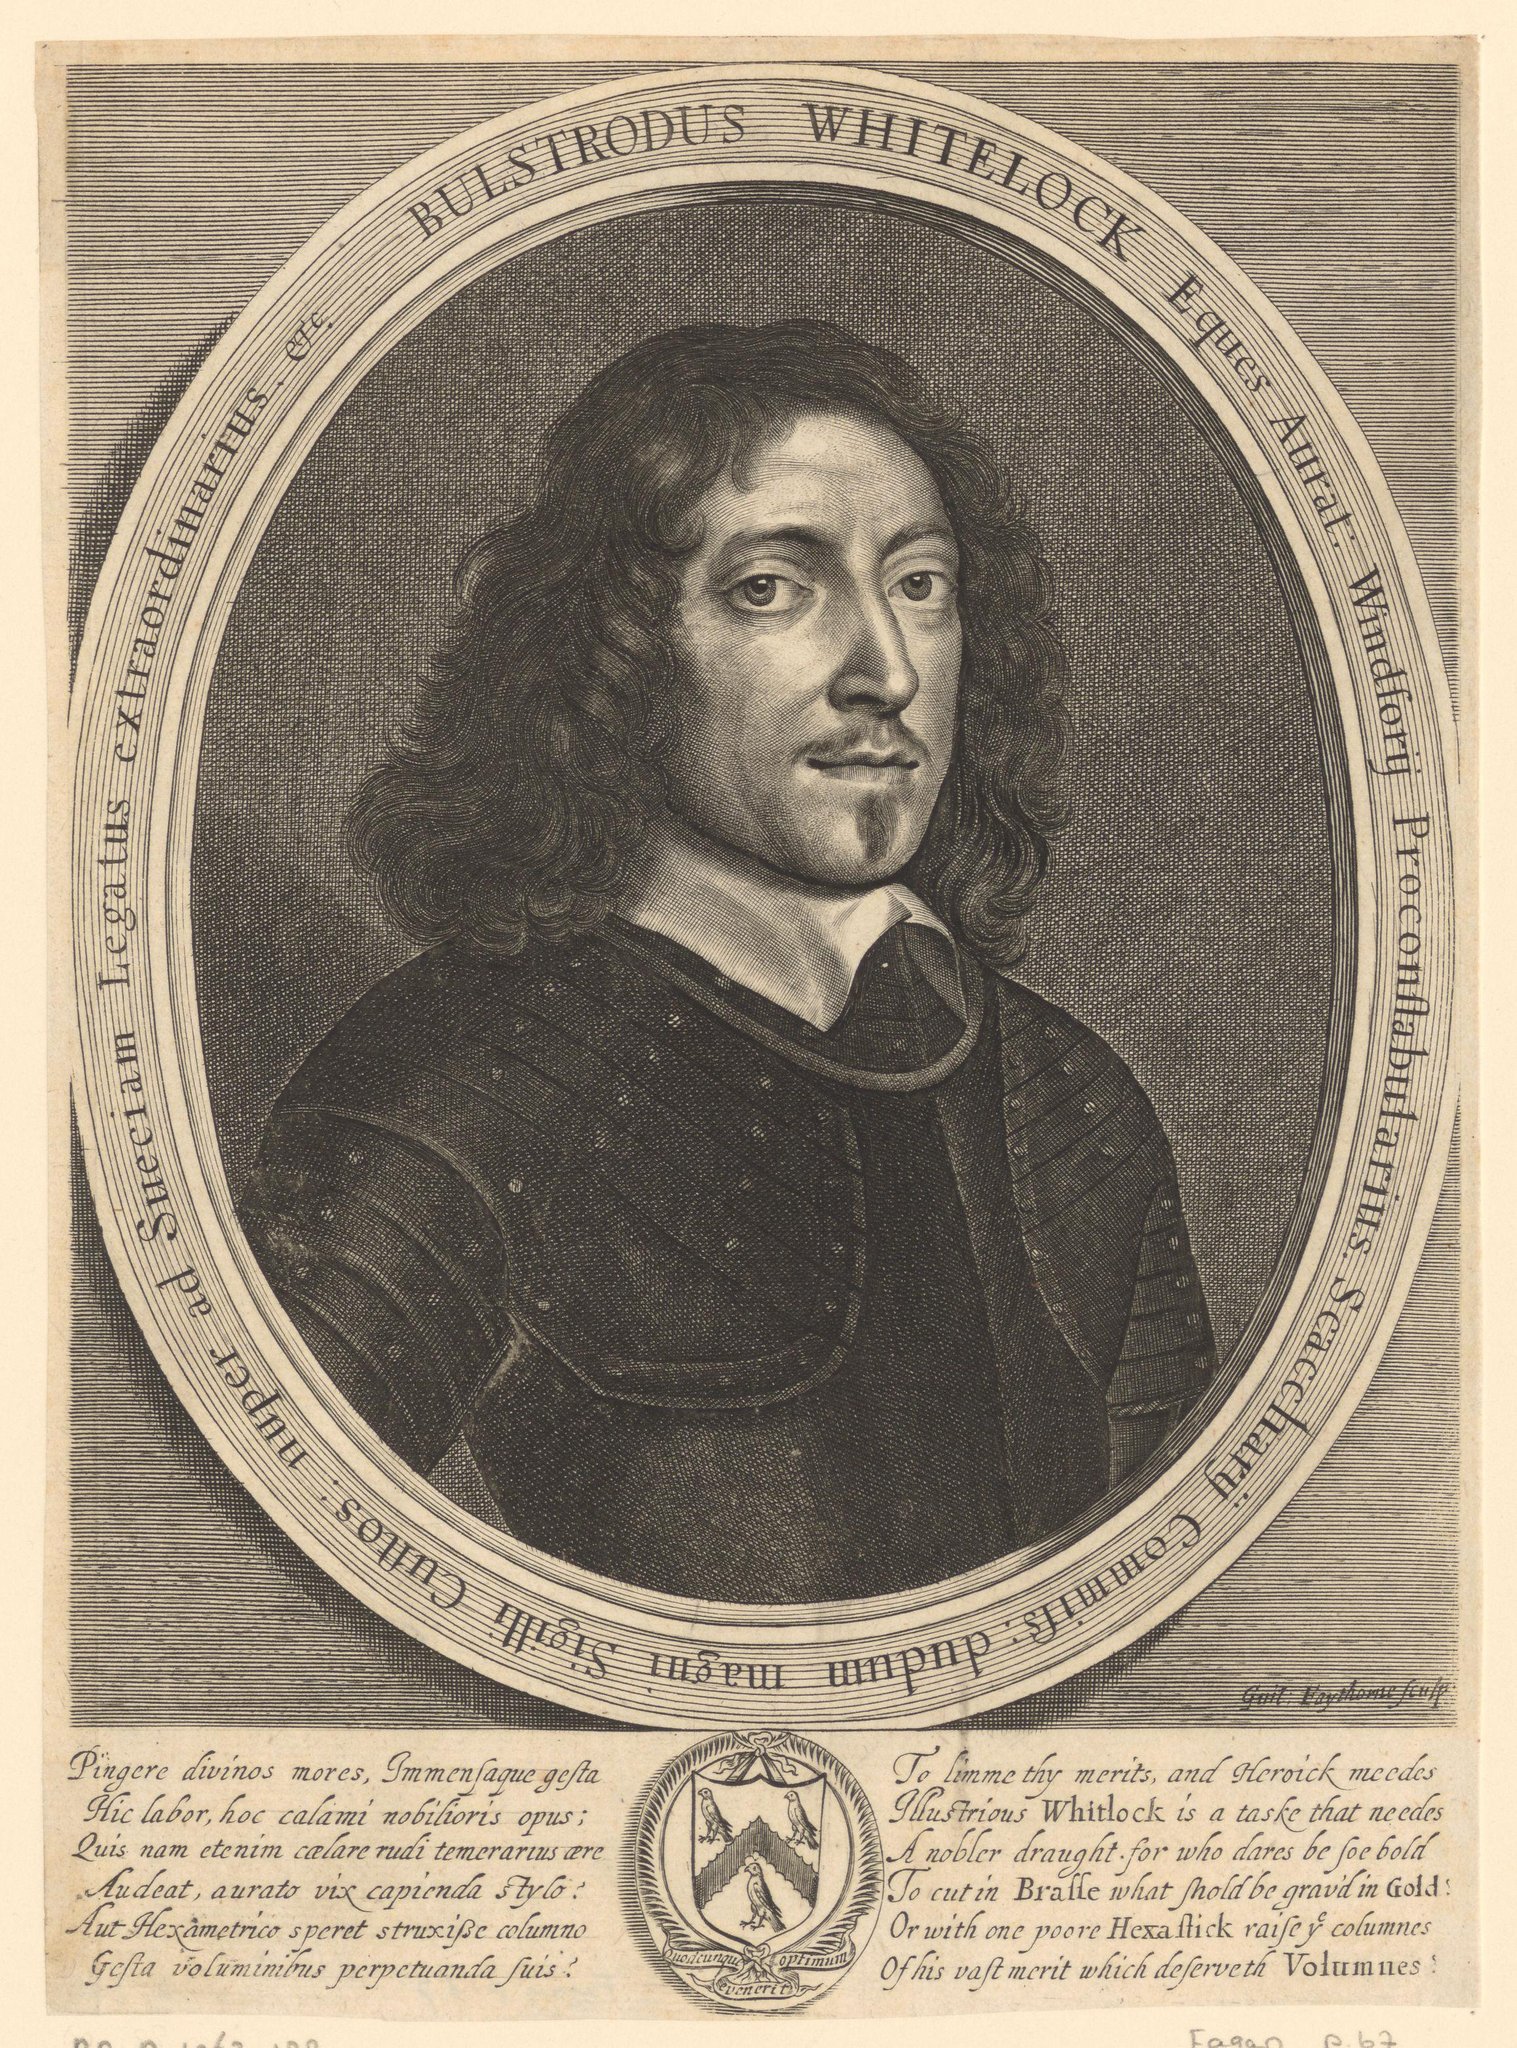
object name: book illustration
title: Portret van Bulstrode Whitelocke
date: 1656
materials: paper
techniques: engraving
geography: london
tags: politician, historical persons, politician, e.g. party leader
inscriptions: collector's mark: Lugt 2228, collector's mark: Lugt 2760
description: Prent uit: Fisher, Payne. Piscatoris Poemata (...). Londen: Edward Blackmore, 1656.